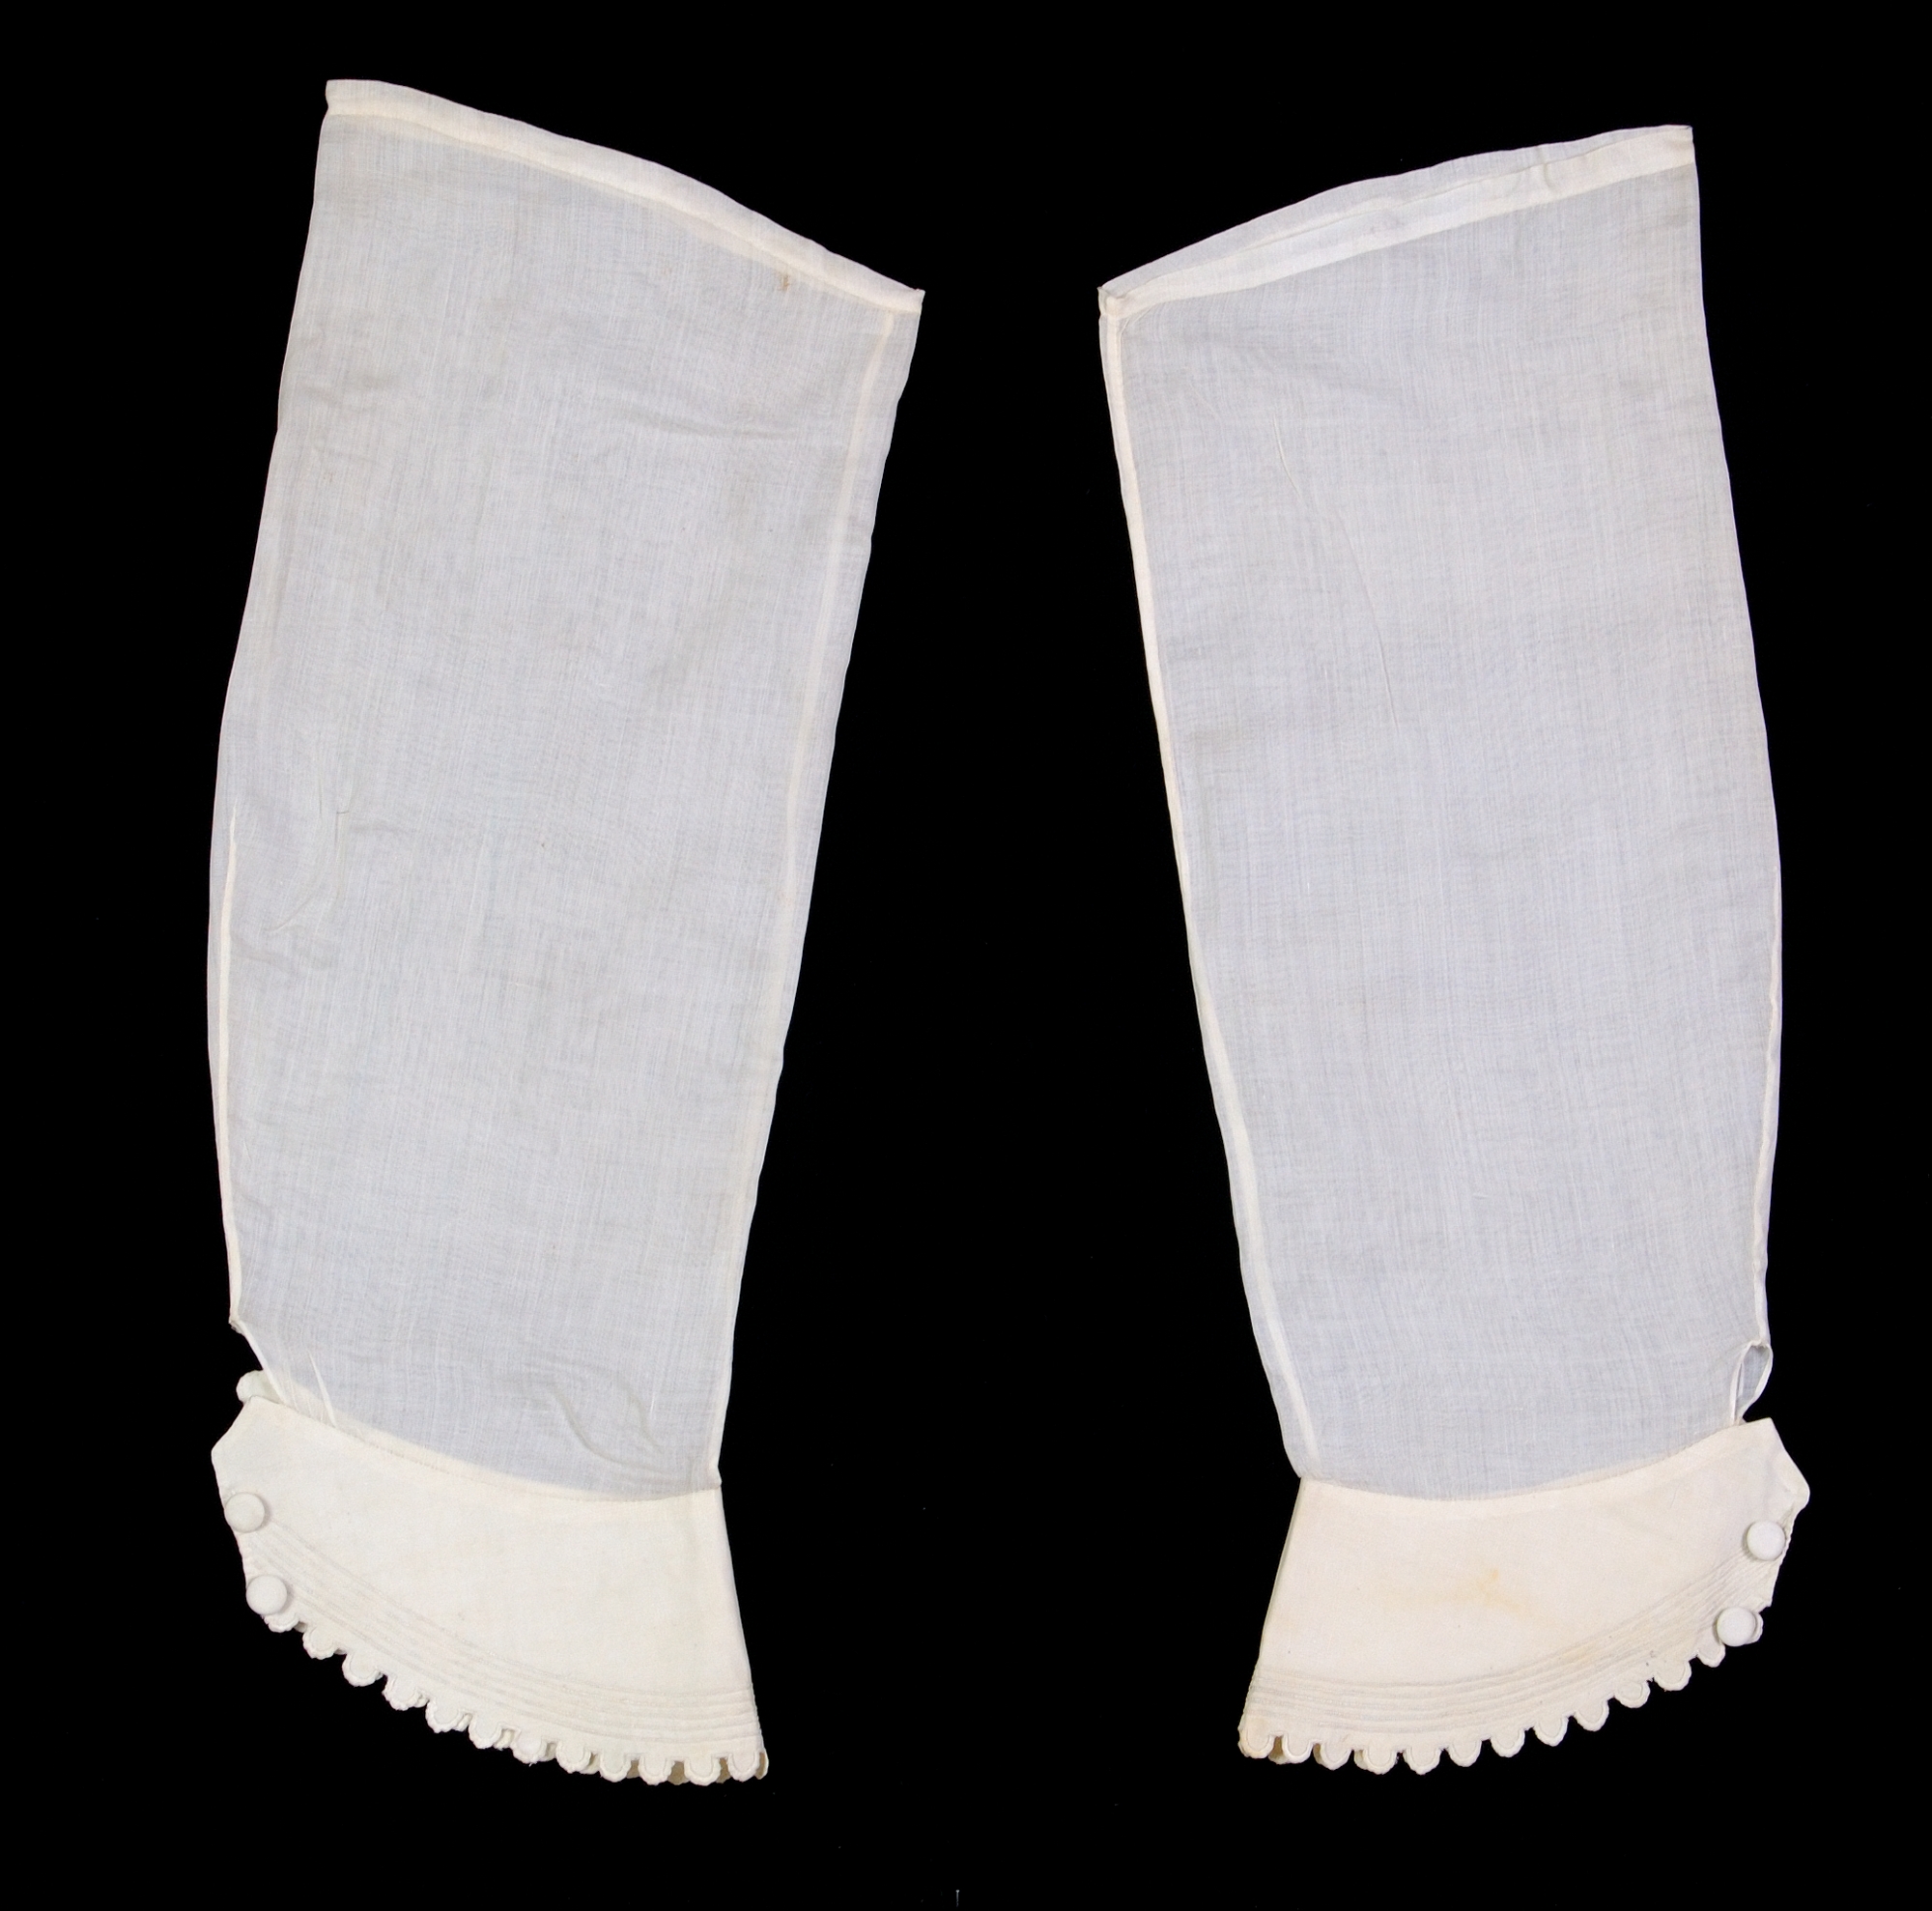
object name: undersleeves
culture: american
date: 1870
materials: linen